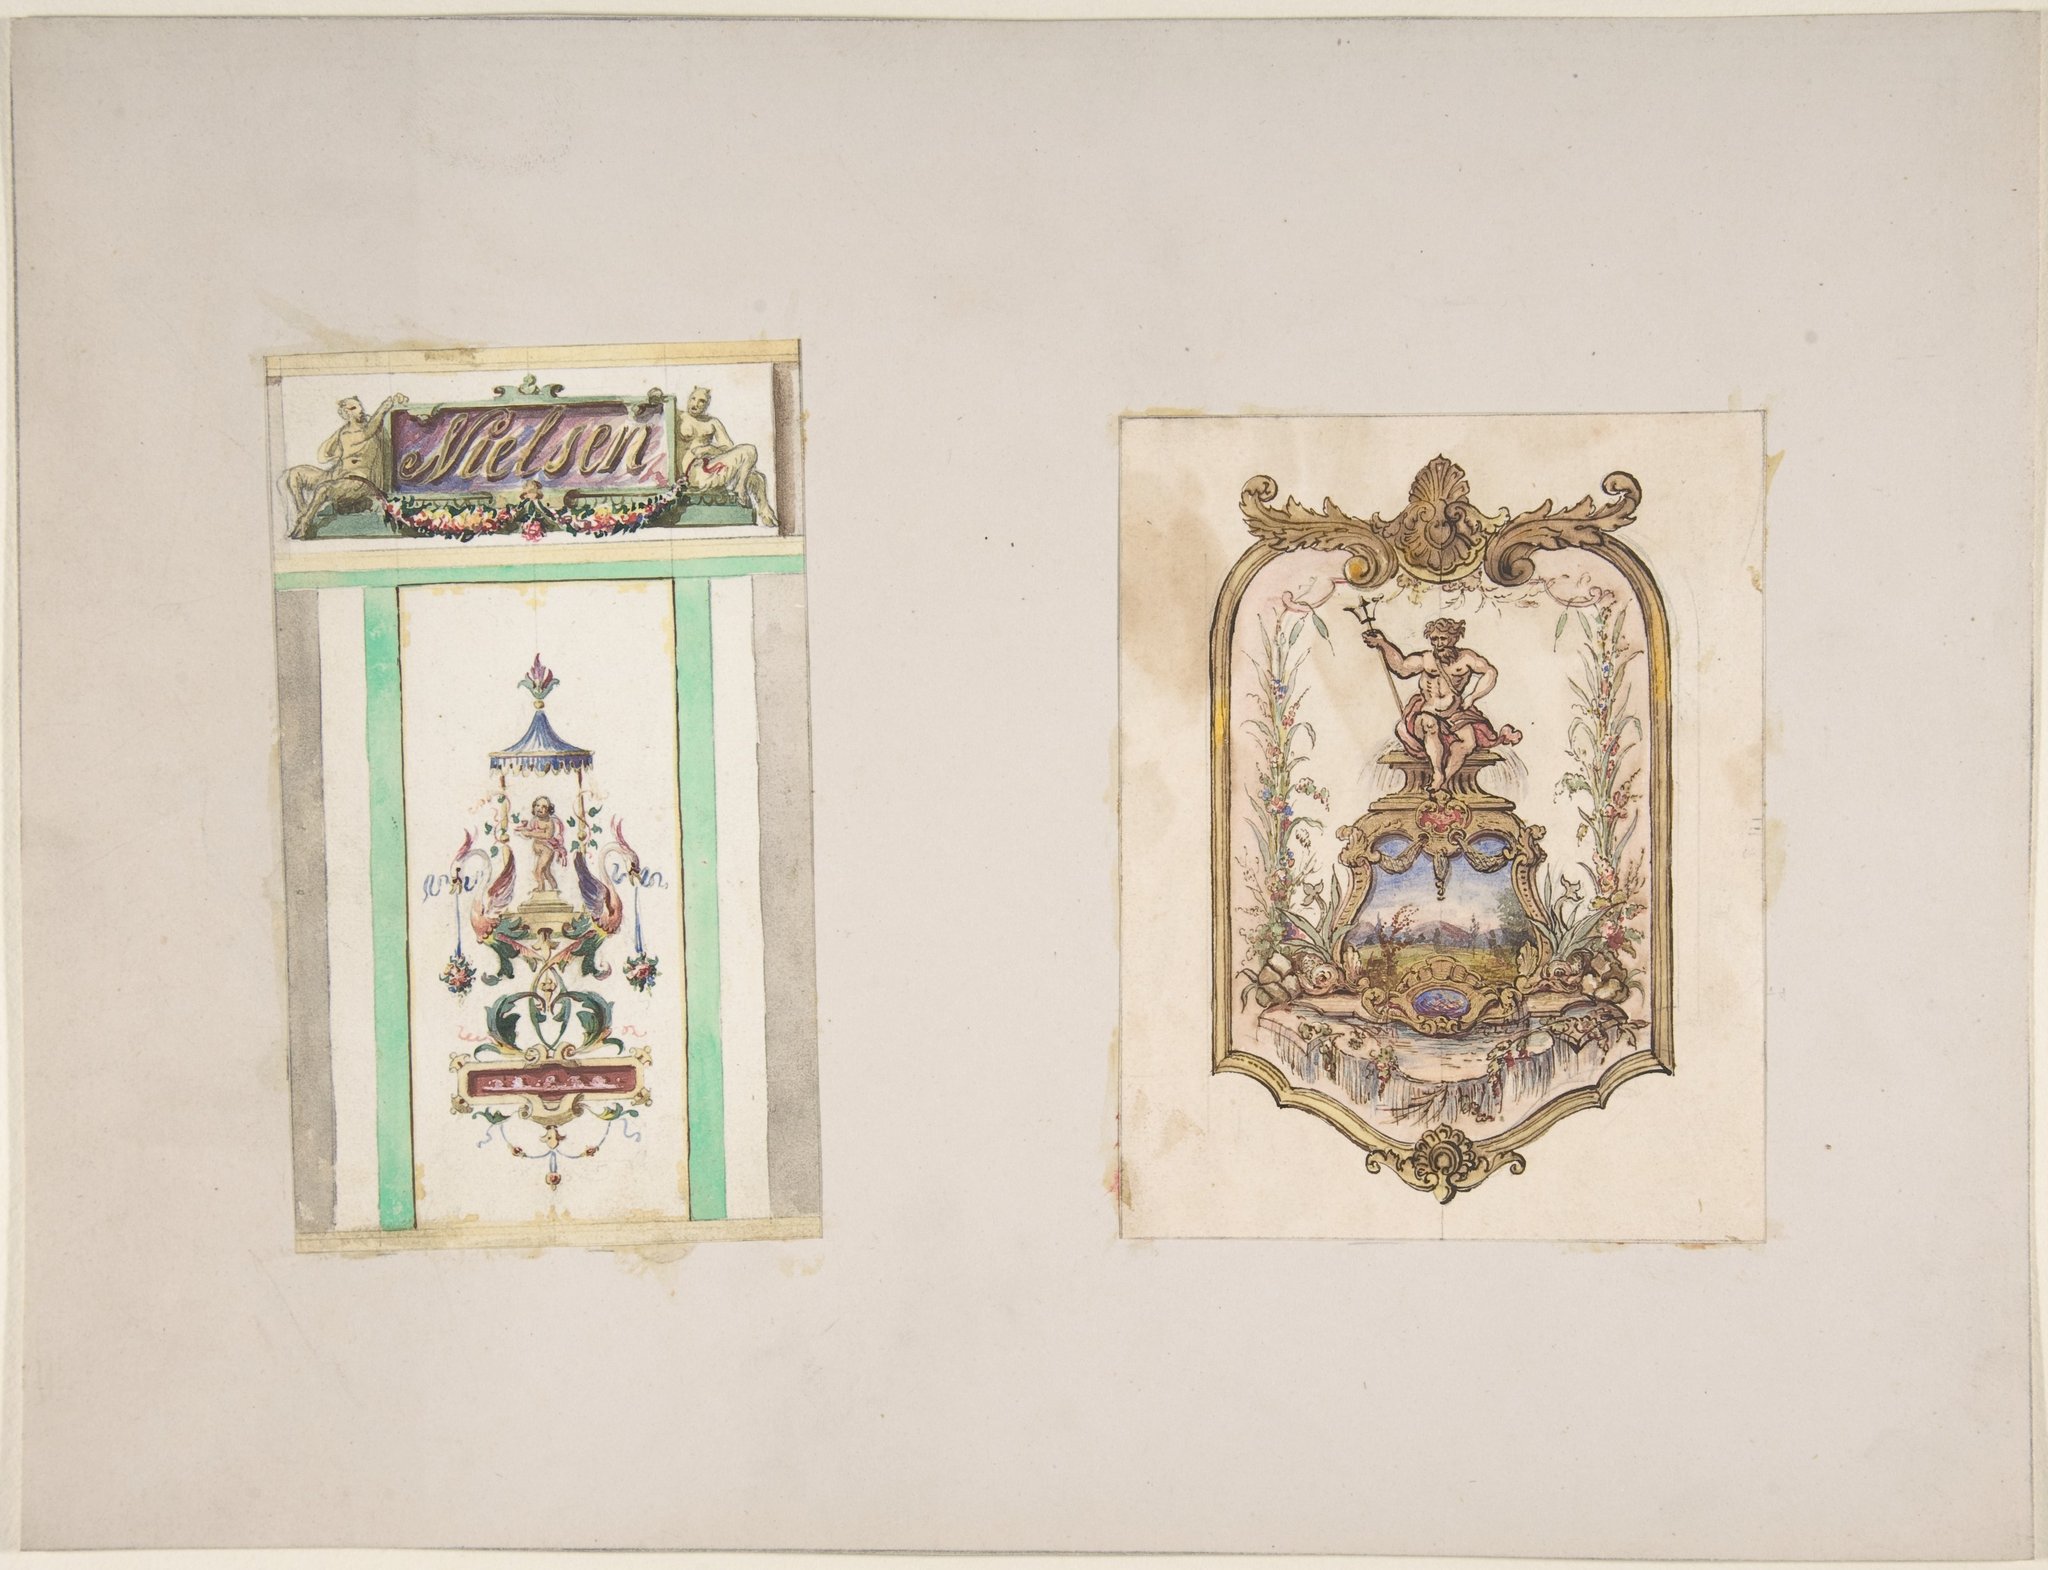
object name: drawing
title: Two Designs for Ornamental Panels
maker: jules-edmond-charles lachaise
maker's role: artist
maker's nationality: french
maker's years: 1897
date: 1851-1900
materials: gilt, graphite, ink, watercolor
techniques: pen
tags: garlands,men,landscapes